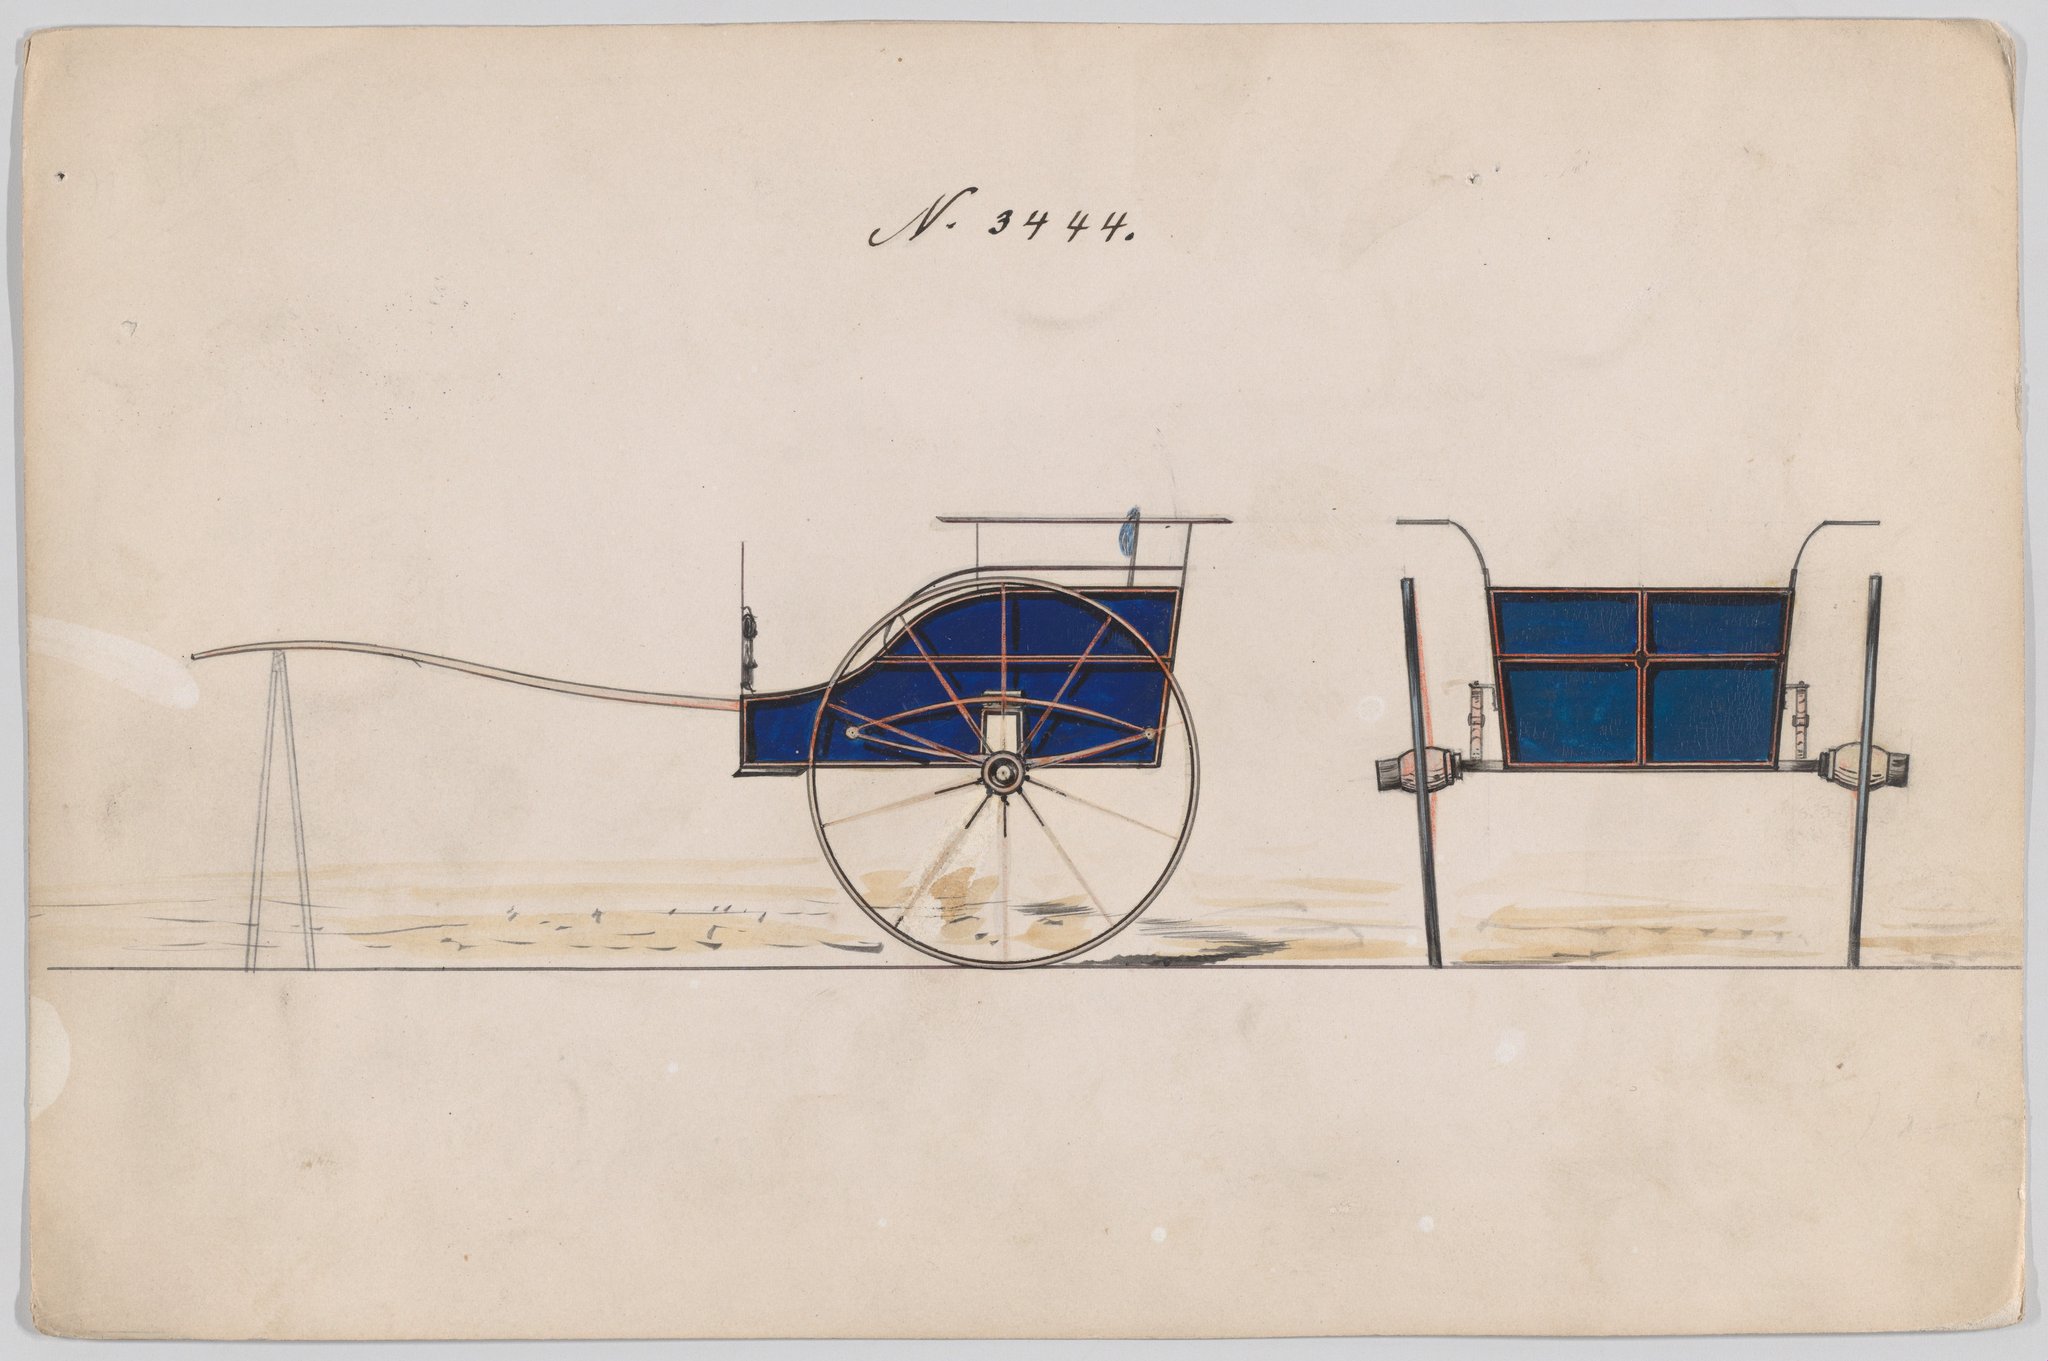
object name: drawing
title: Villiage Cart #3444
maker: brewster & co.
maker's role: manufacturer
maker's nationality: american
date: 1878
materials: gouache, gum arabic, ink, watercolor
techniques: pen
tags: carriages